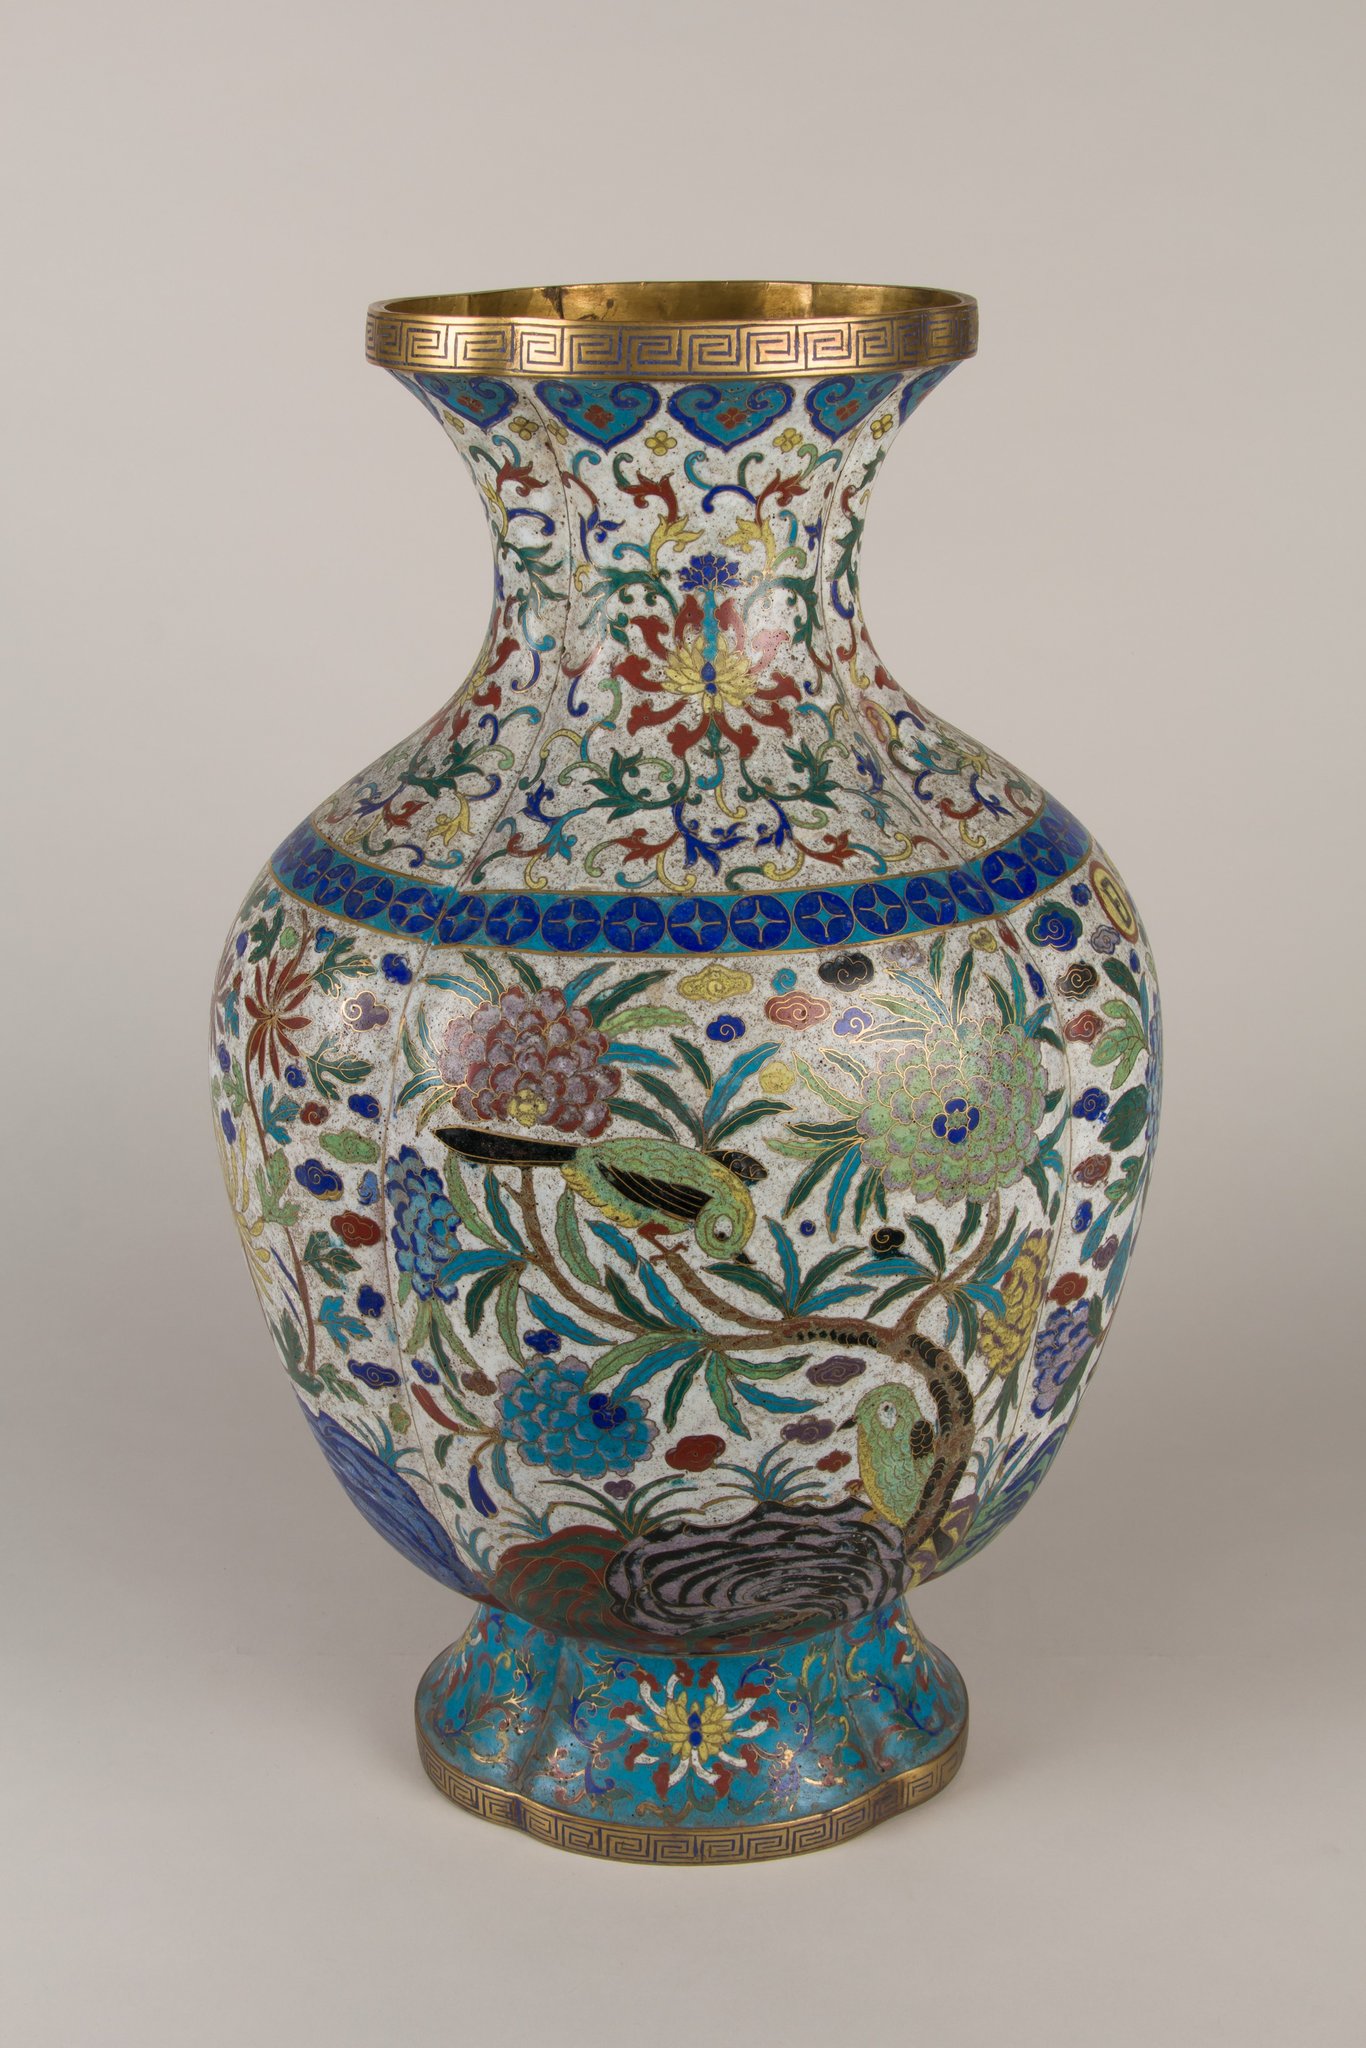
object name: vase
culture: chinese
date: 1736-1795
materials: copper, enamel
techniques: enamel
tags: birds,flowers